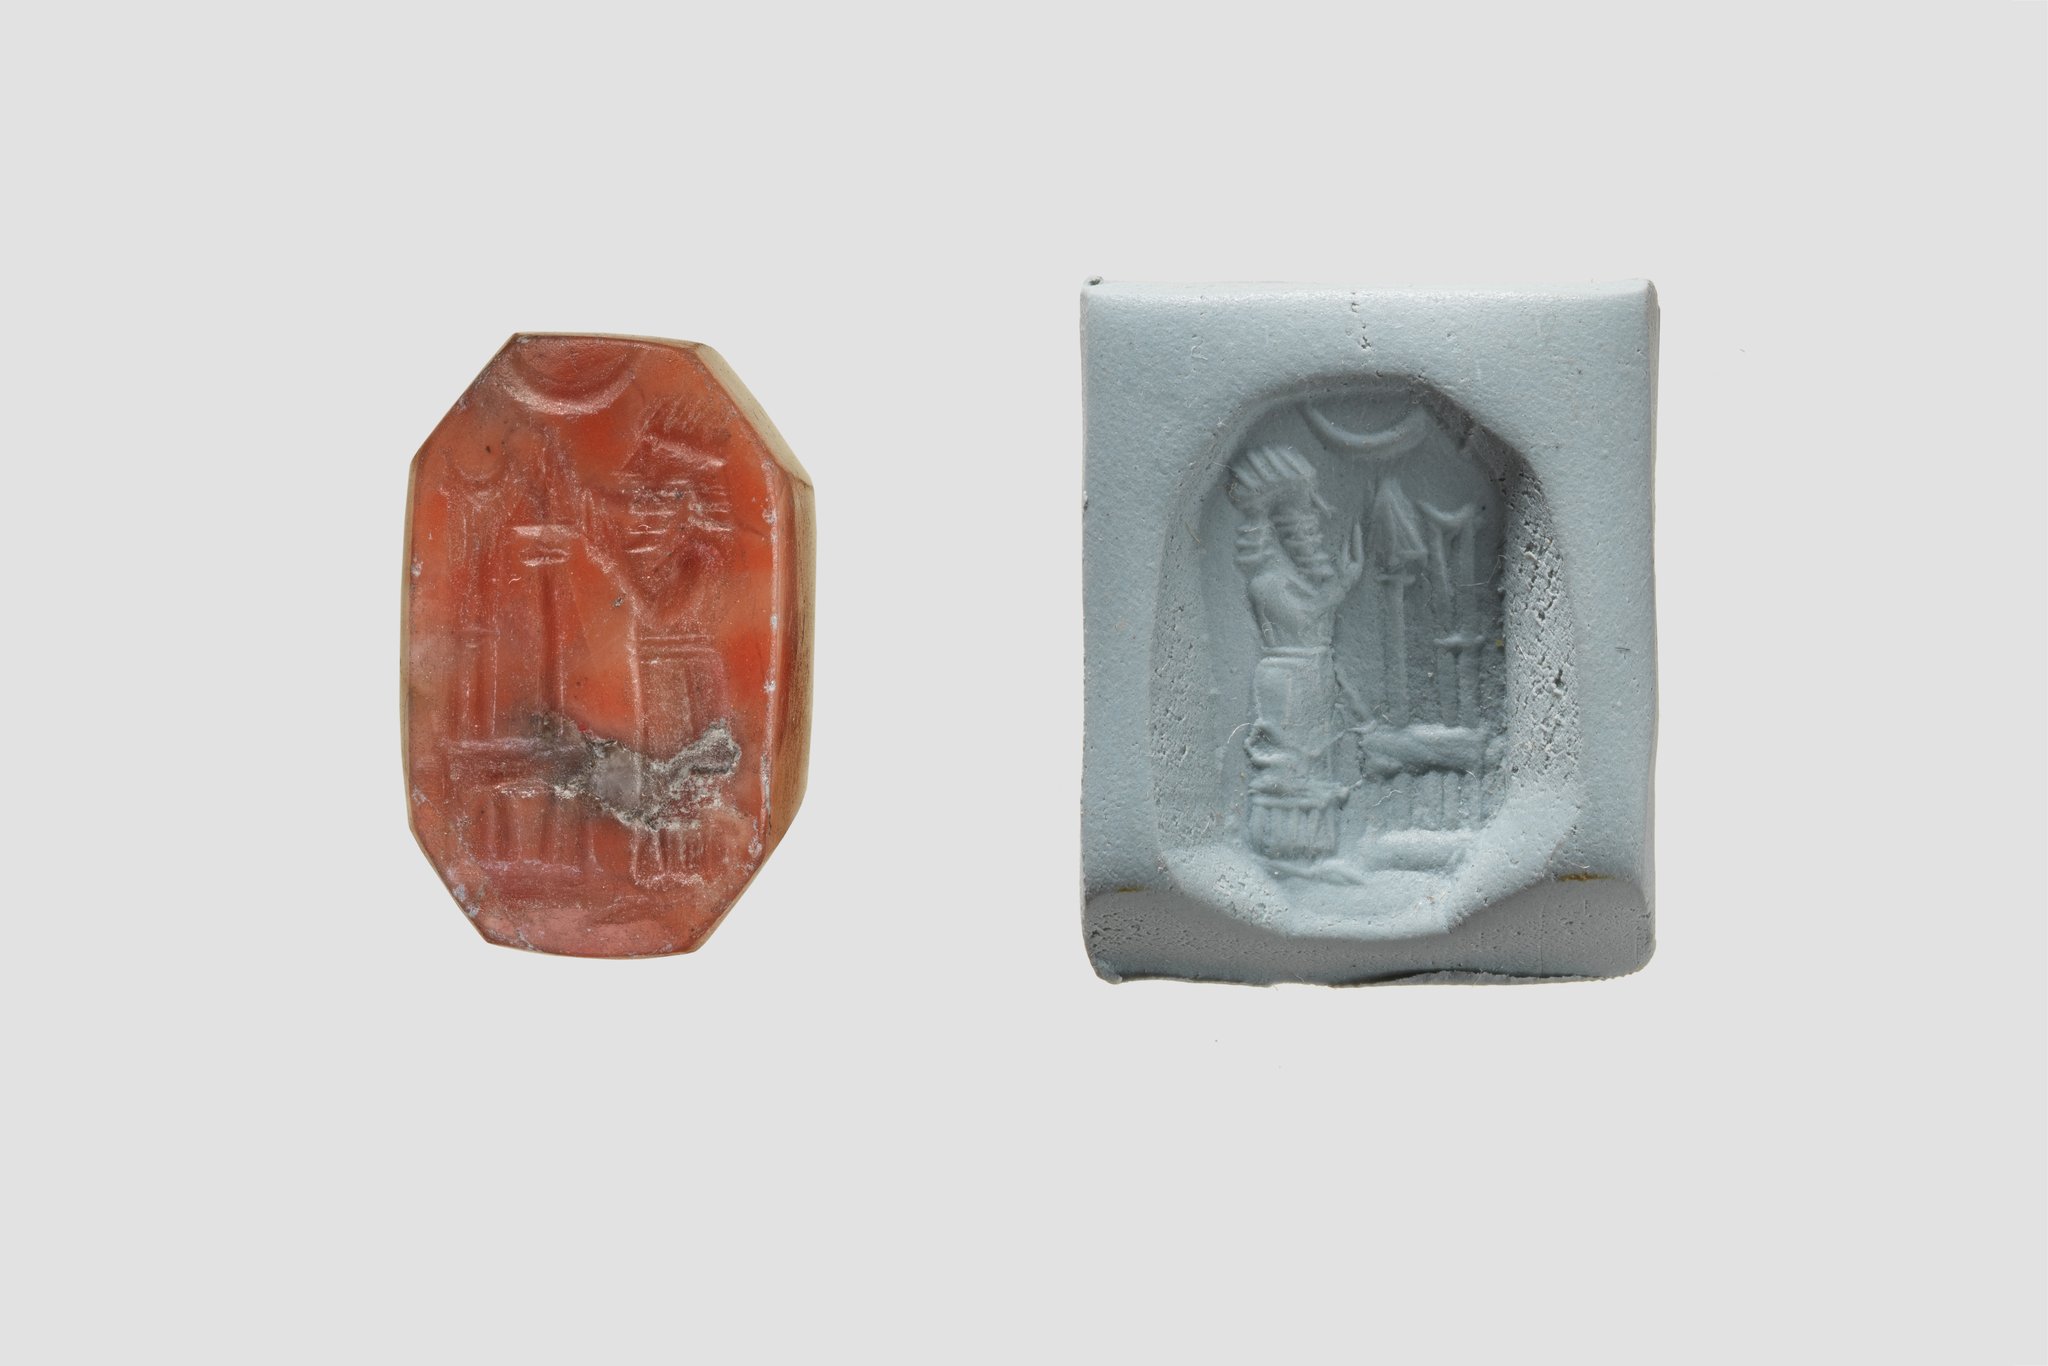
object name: stamp seal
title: Stamp seal (octagonal pyramid) with cultic scene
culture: assyro-babylonian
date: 734-501 BCE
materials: gemstone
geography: mesopotamia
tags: men